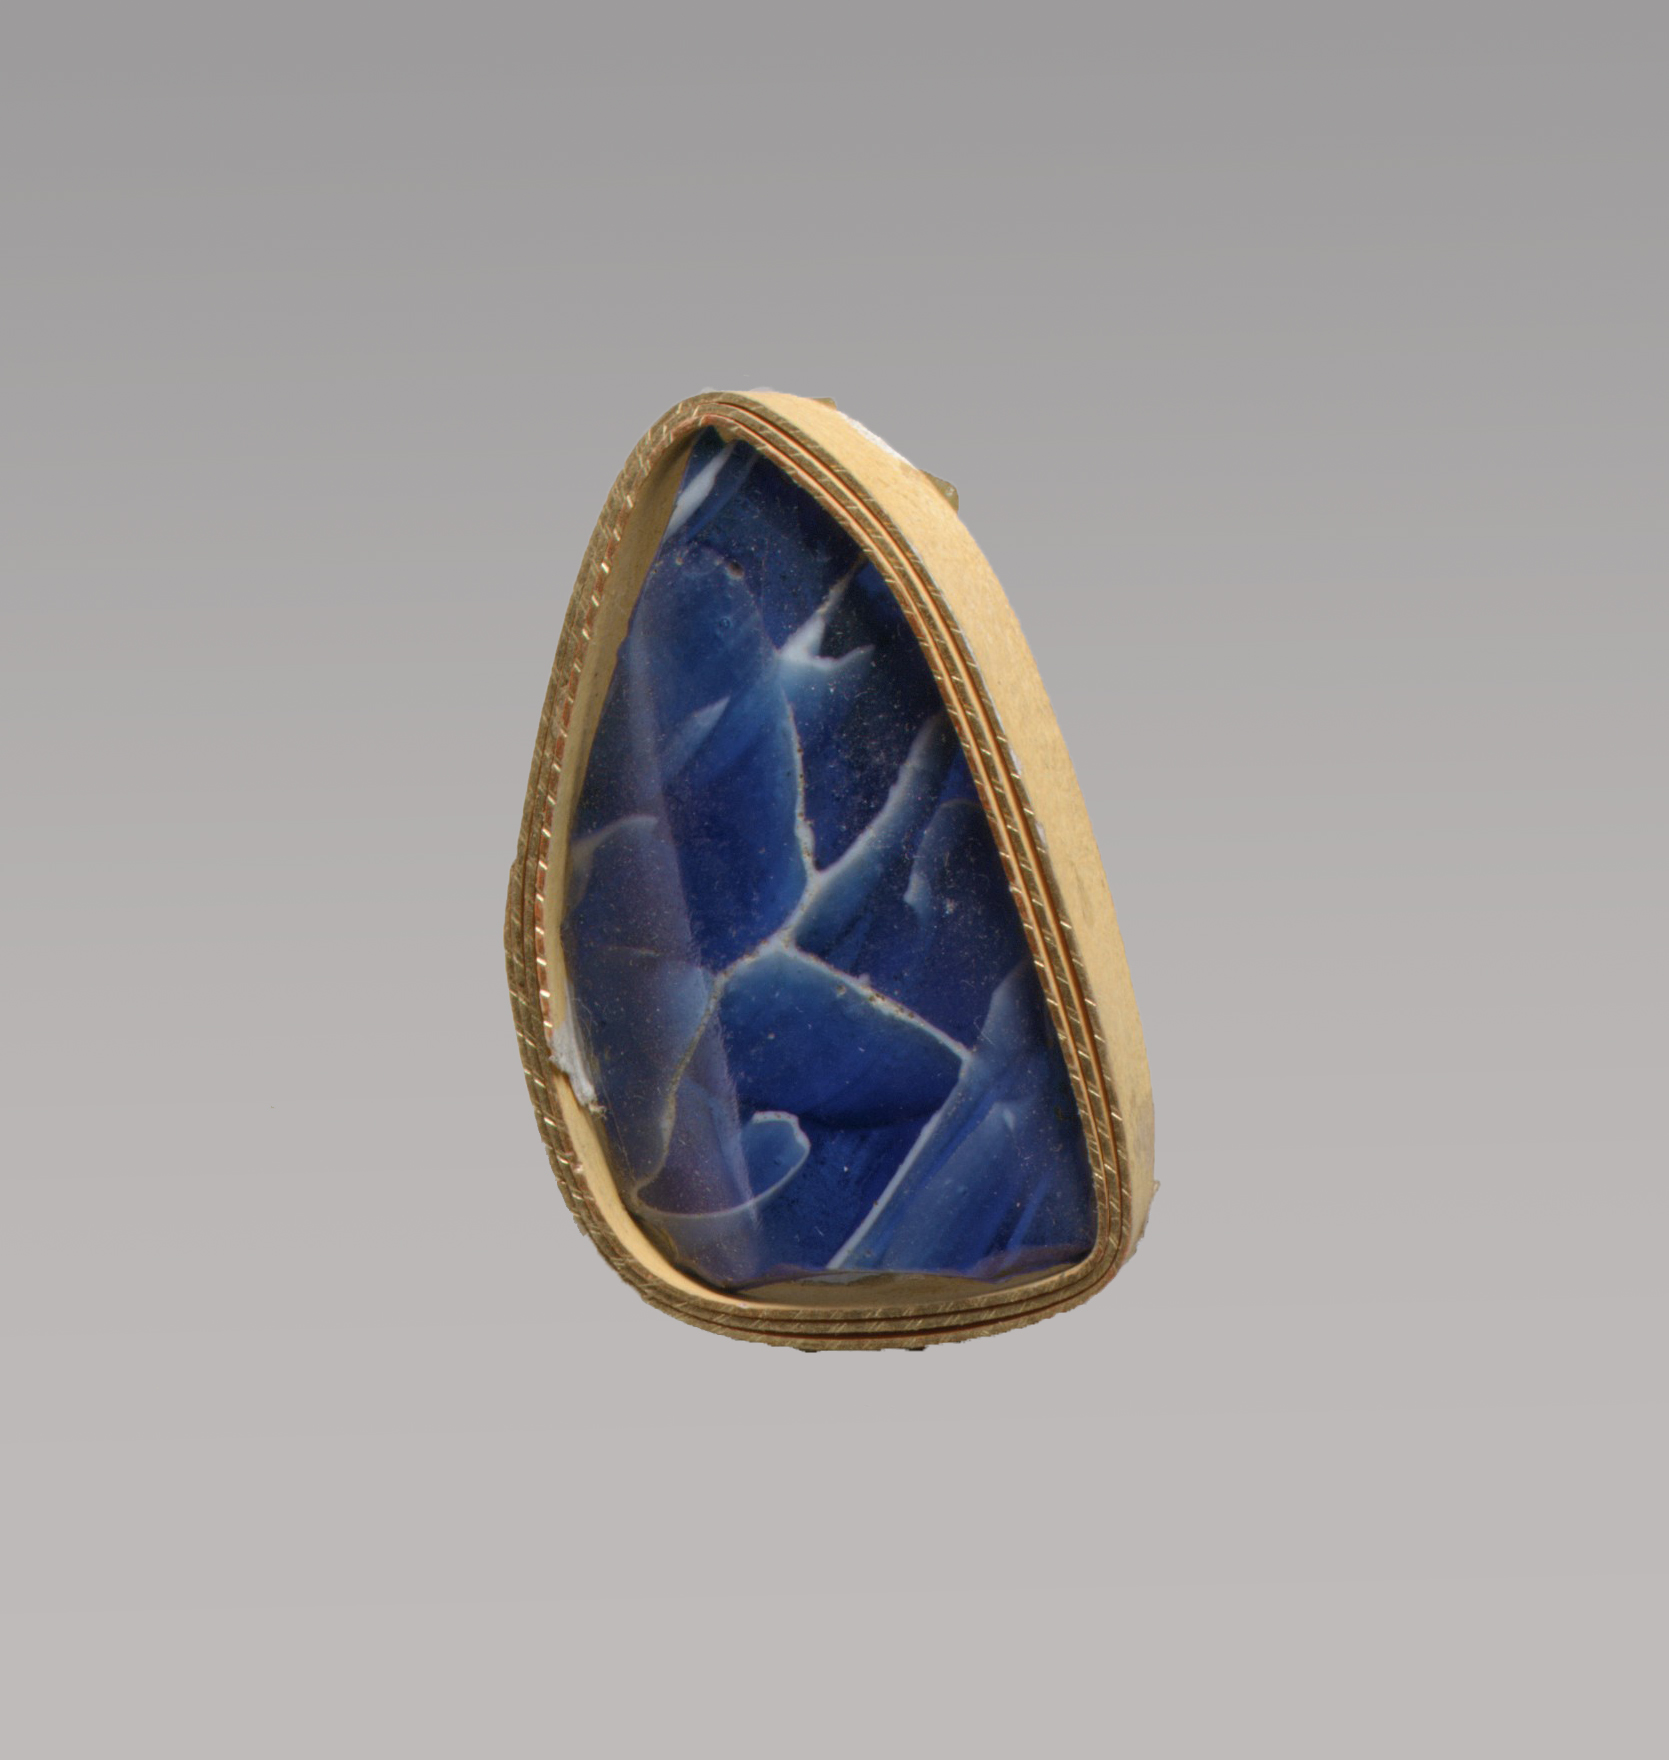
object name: fragment, mosaic bowl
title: Glass mosaic bowl fragment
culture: roman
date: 34 BCE-33 CE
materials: glass